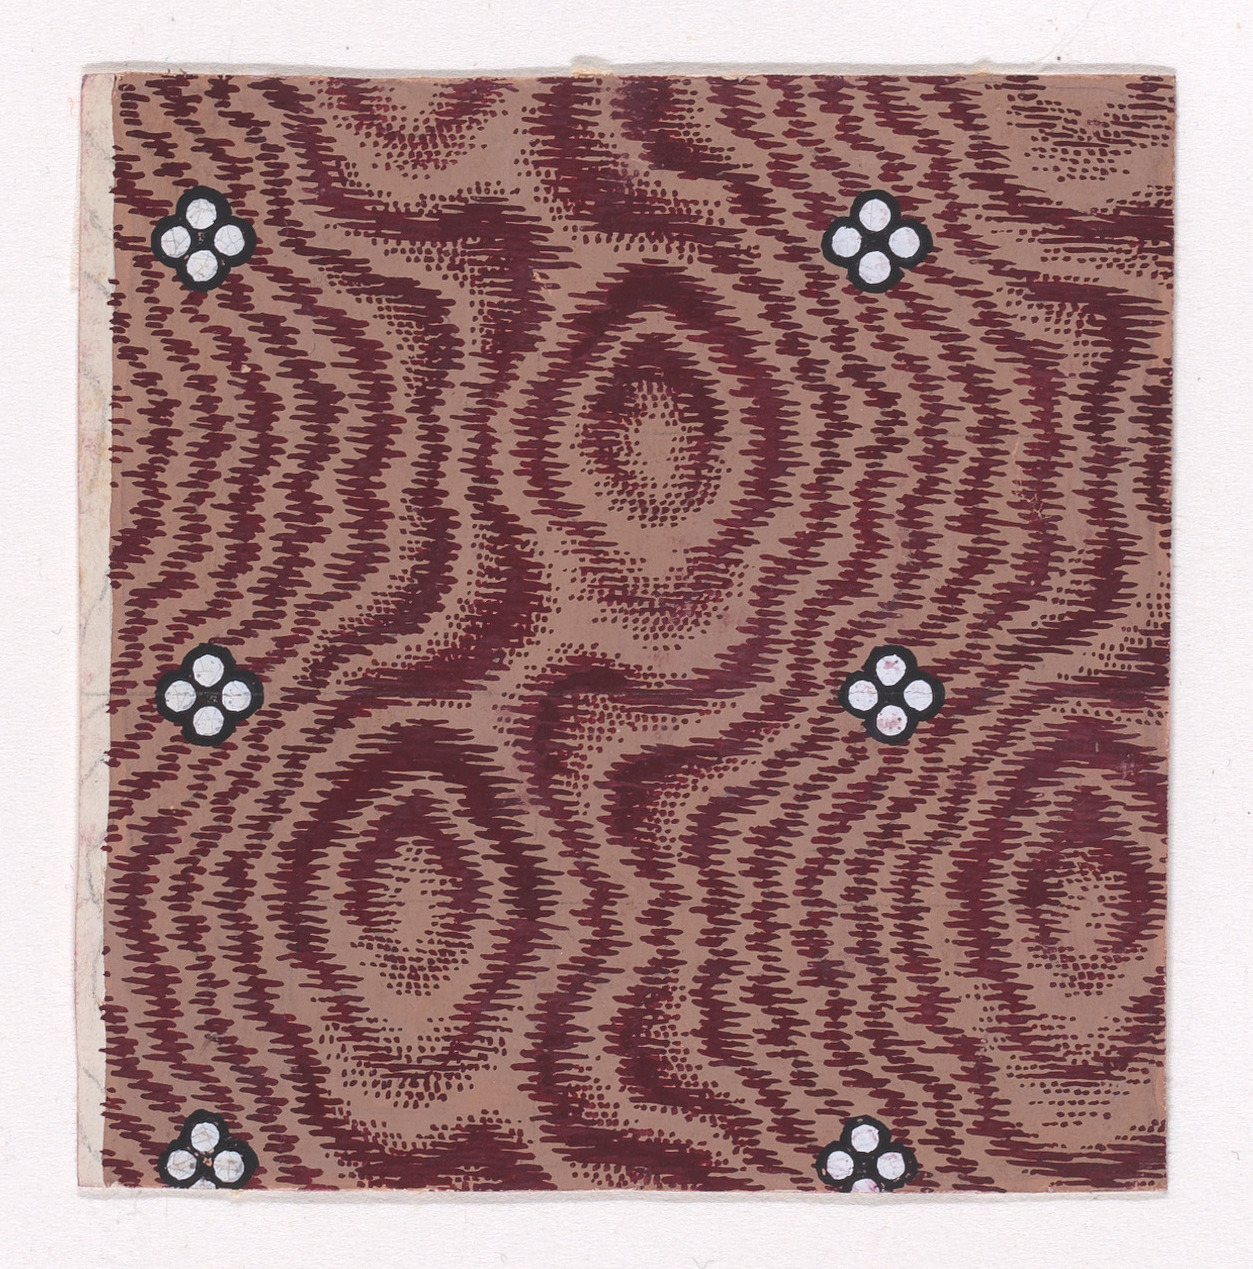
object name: drawing ornament architecture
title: Textile Design with Vertical Strips of Quatrefoils of Pearls Over an Abstract Background that Simulates Tie-Dye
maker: anonymous, alsatian, 19th century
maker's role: artist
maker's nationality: alsatian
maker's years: 1800-1900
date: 1840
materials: gouache